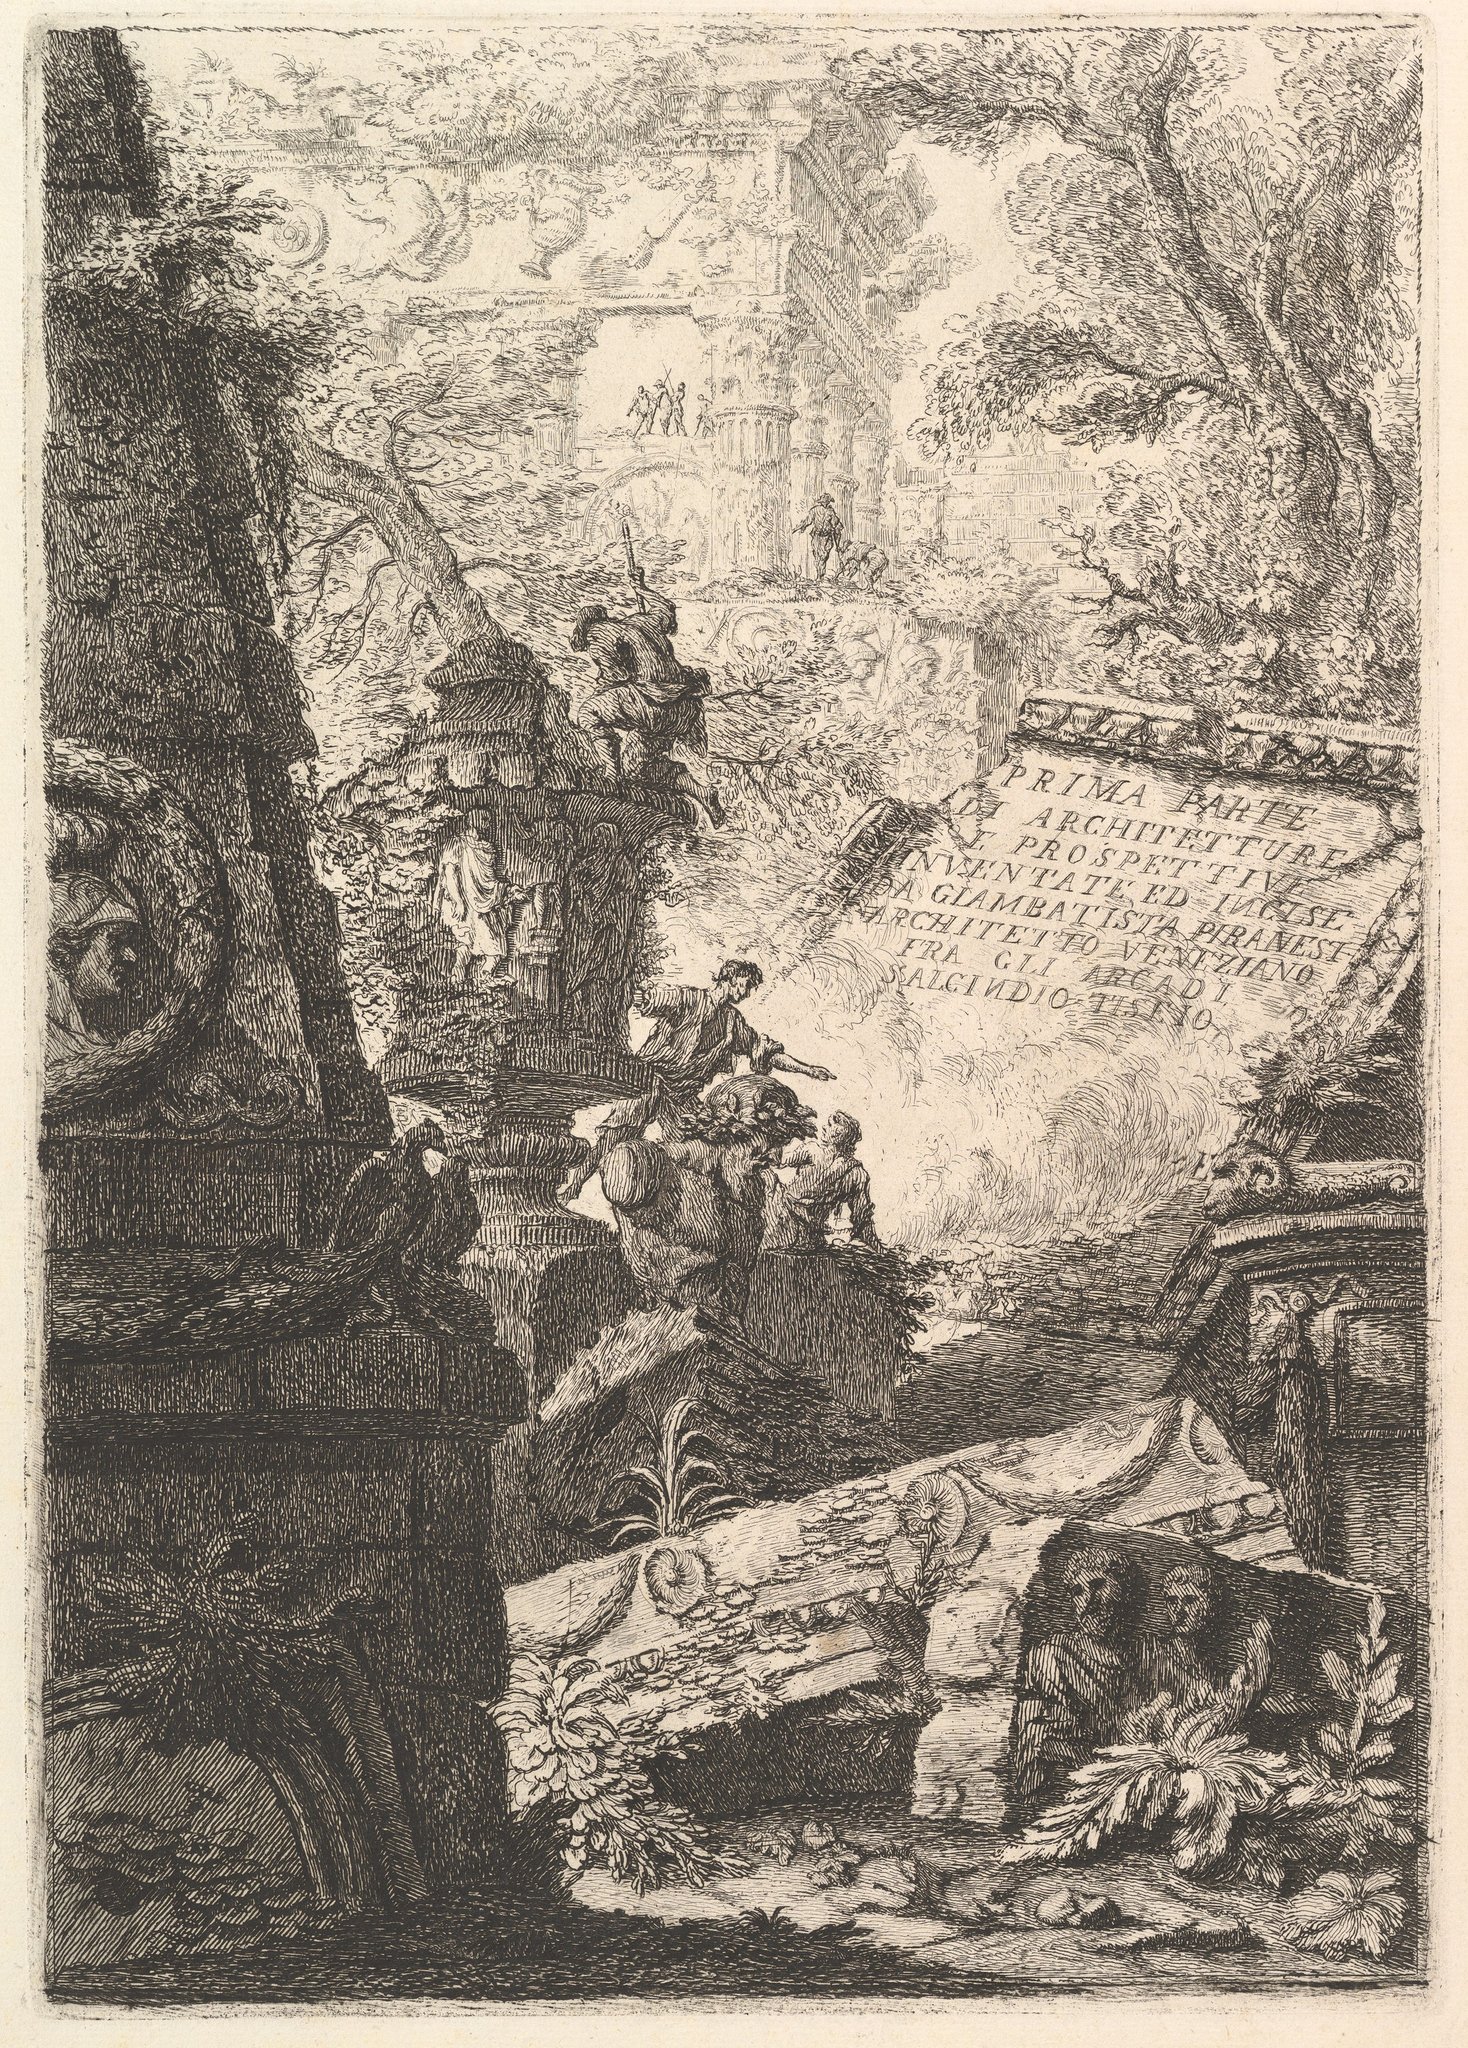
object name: print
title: Frontispiece from "Prima Parte di Architetture, e Prospettive"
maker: giovanni battista piranesi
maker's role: artist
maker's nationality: italian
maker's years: 1720-1778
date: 1750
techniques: etching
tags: human figures,ruins